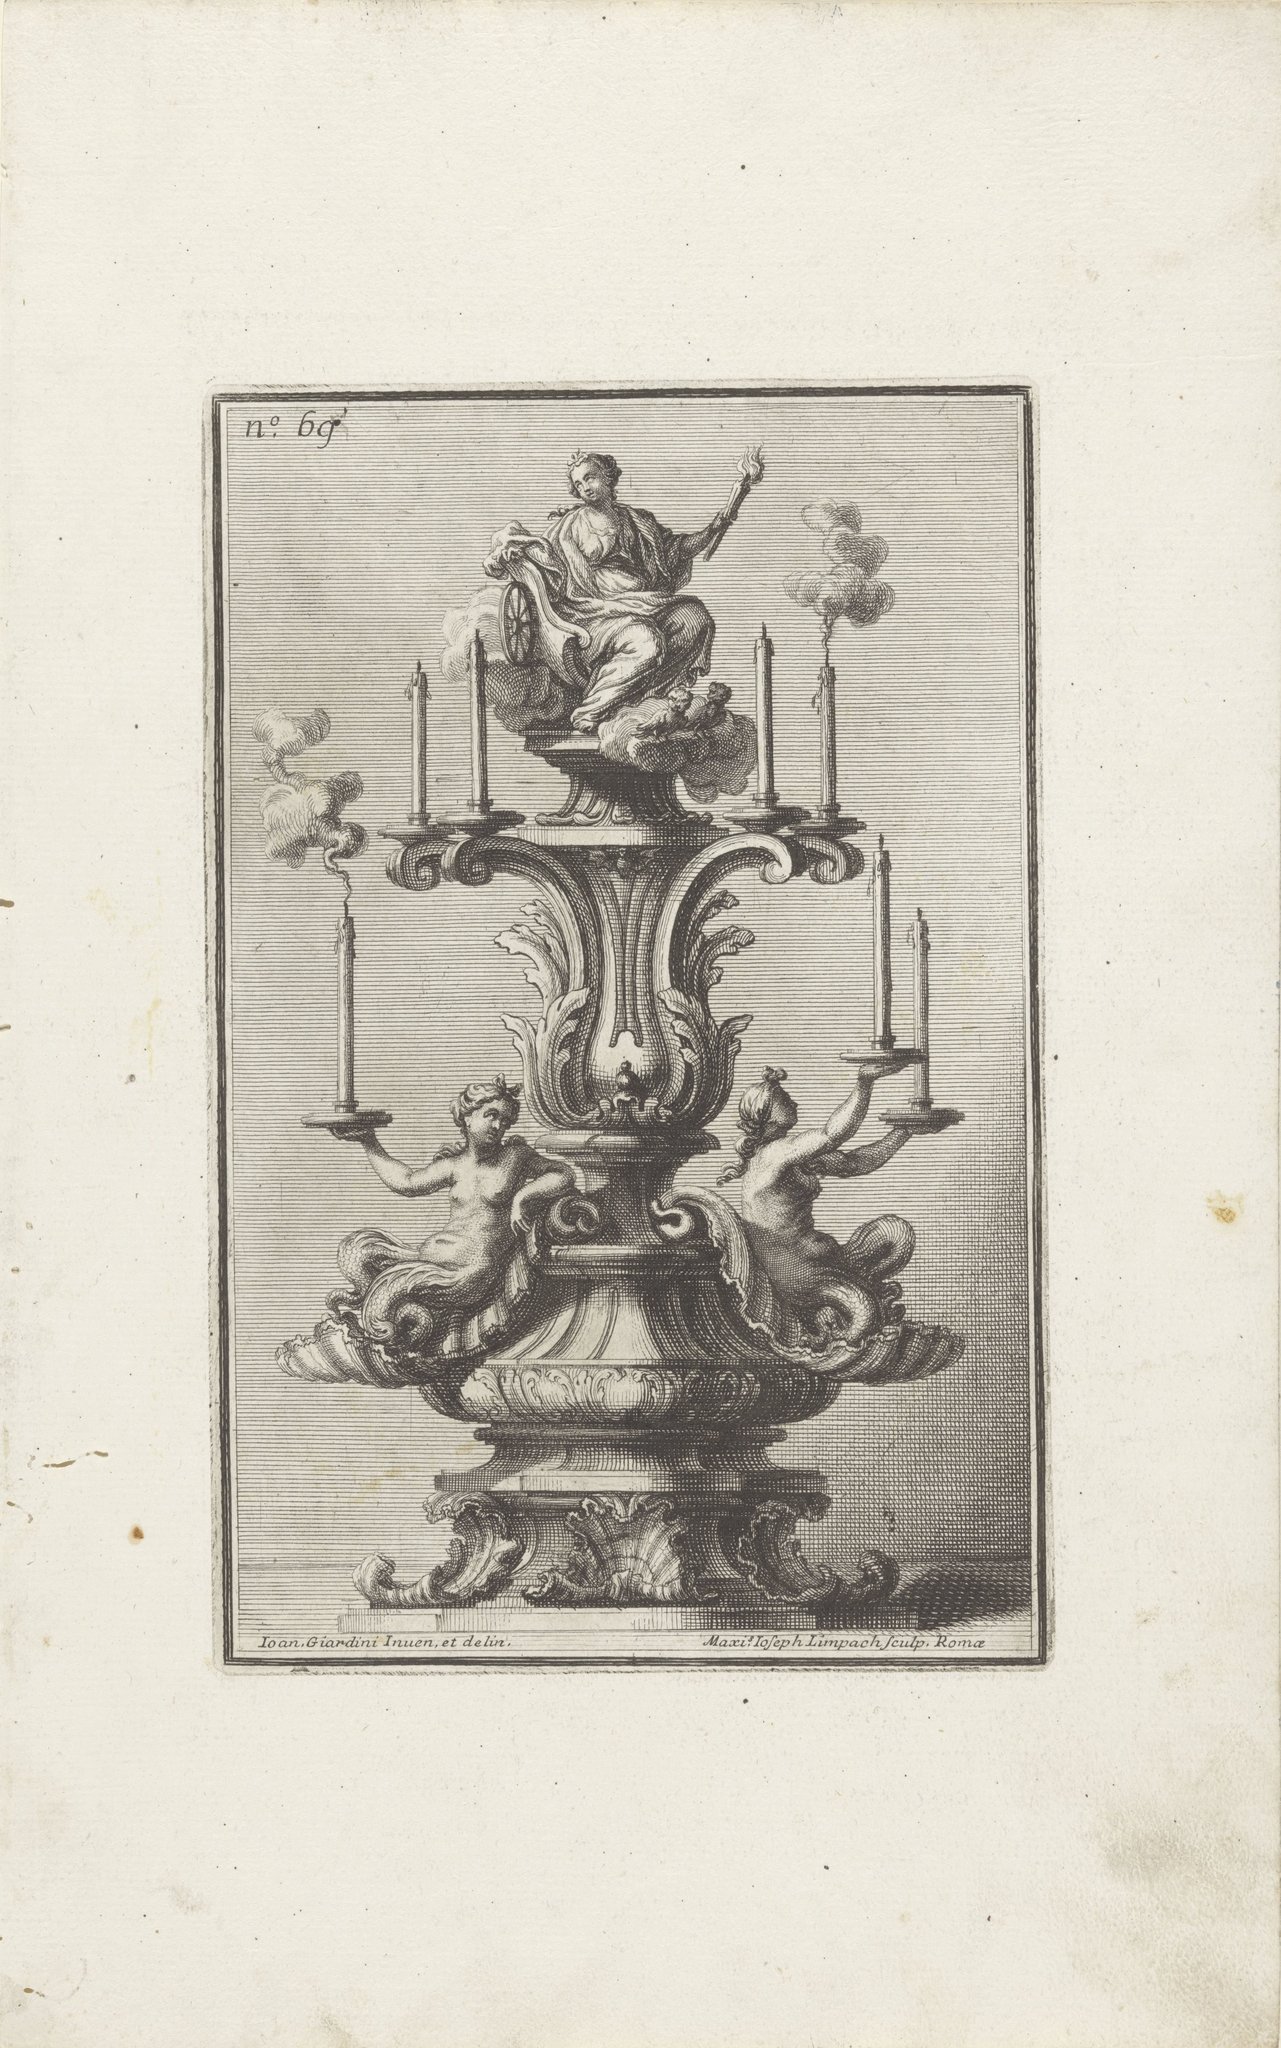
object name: print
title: Diverse kerkelijke voorwerpen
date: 1714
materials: paper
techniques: etching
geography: rome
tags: nereids, daughters of nereus; sea-nymphs, chandelier, candelabrum, ornament ~ candelabrum, personification of the night, 'nox'; 'notte', 'carro della notte', 'serenità della notte' (ripa), candle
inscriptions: collector's mark: Lugt 2228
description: Prent maakt deel uit van een reeks van 100 ornamentprenten naar ontwerp van Giovanni Giardini.